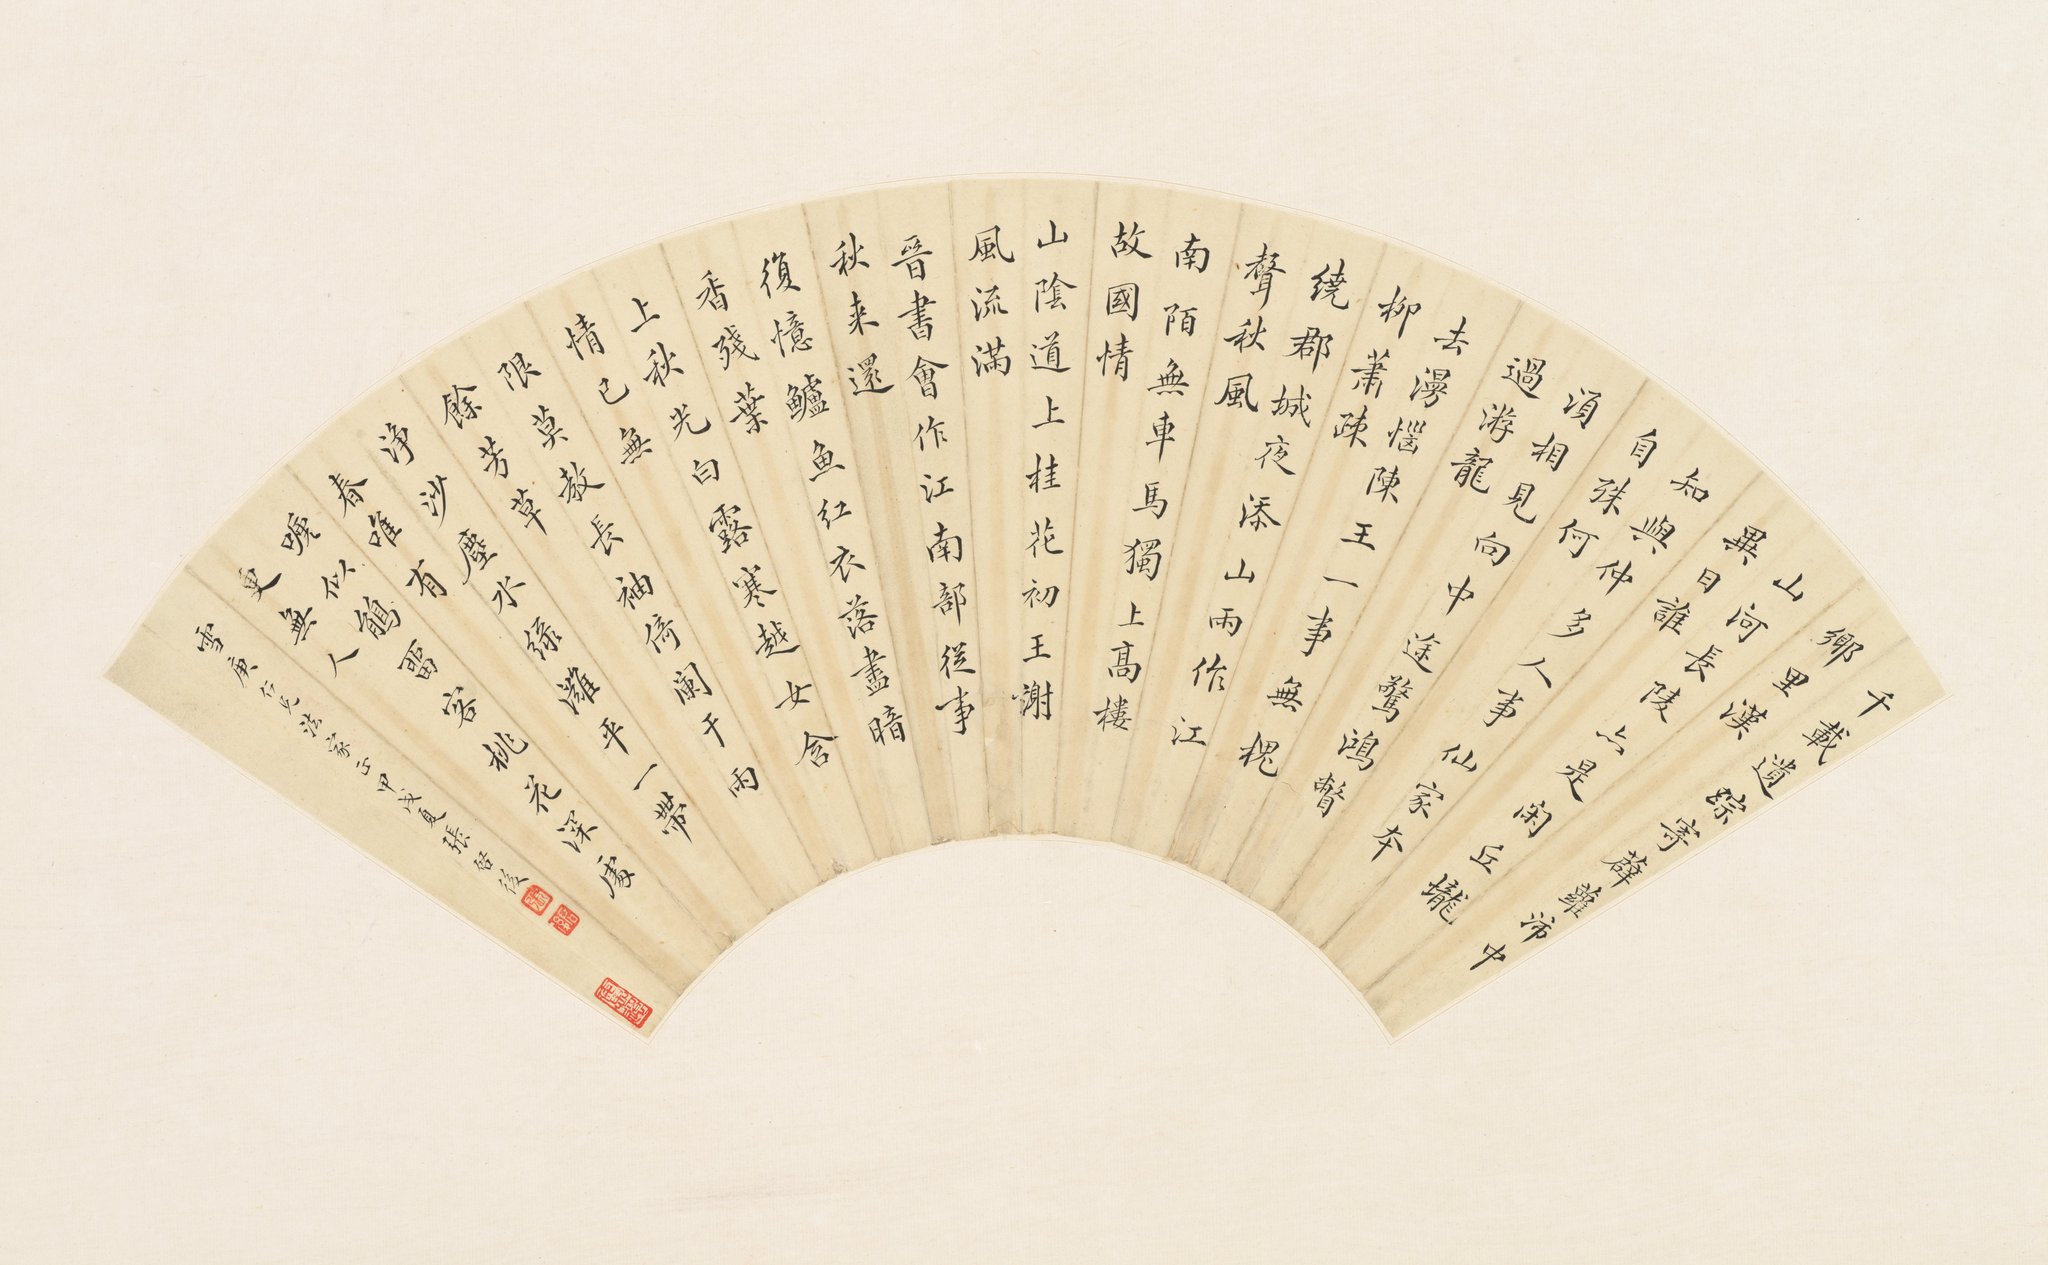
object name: folding fan mounted a an album leaf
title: Poems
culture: chinese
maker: zhang qihou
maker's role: artist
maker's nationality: chinese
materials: ink, paper